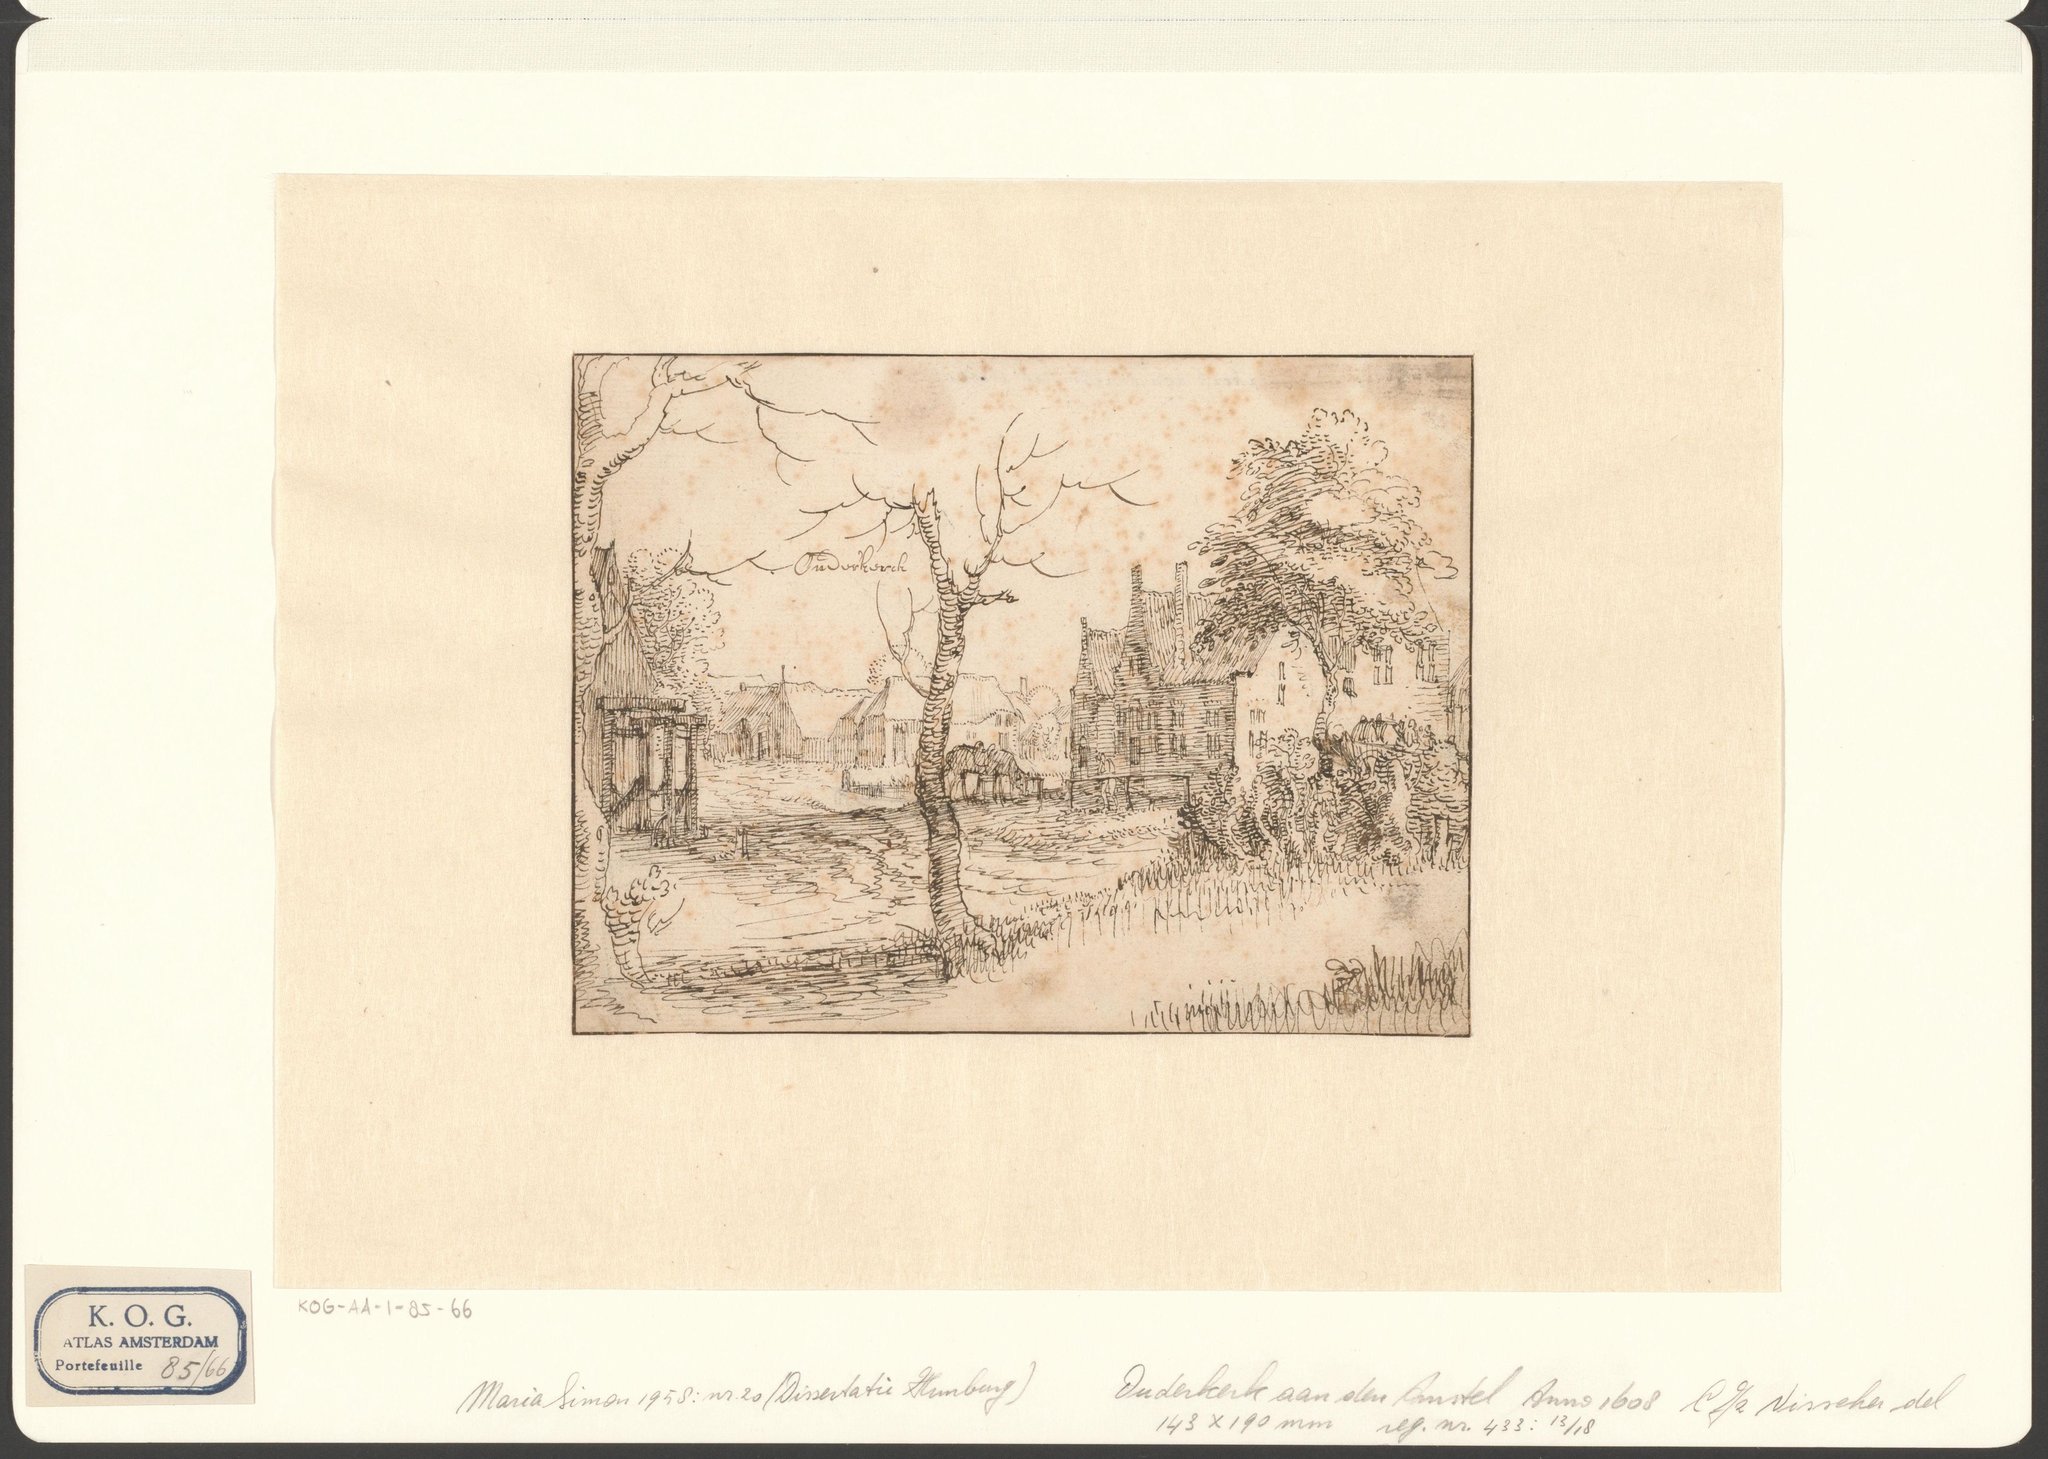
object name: drawing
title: Gezicht op Ouderkerk aan de Amstel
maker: claes jansz. visscher (ii)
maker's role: draughtsman, print maker, publisher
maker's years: 1586-1652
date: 1608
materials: chalk, ink, paper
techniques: pen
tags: village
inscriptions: inscription: ‘Maria Simon 1958 (...) C Jz Visscher del’, inscription: ‘Ouderkerk a/d Amstel 1608’, signature: ‘C.J. Visscher’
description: Onderwerpsrubriek binnen de Atlas Amsterdam: Ouderkerk aan de Amstel.